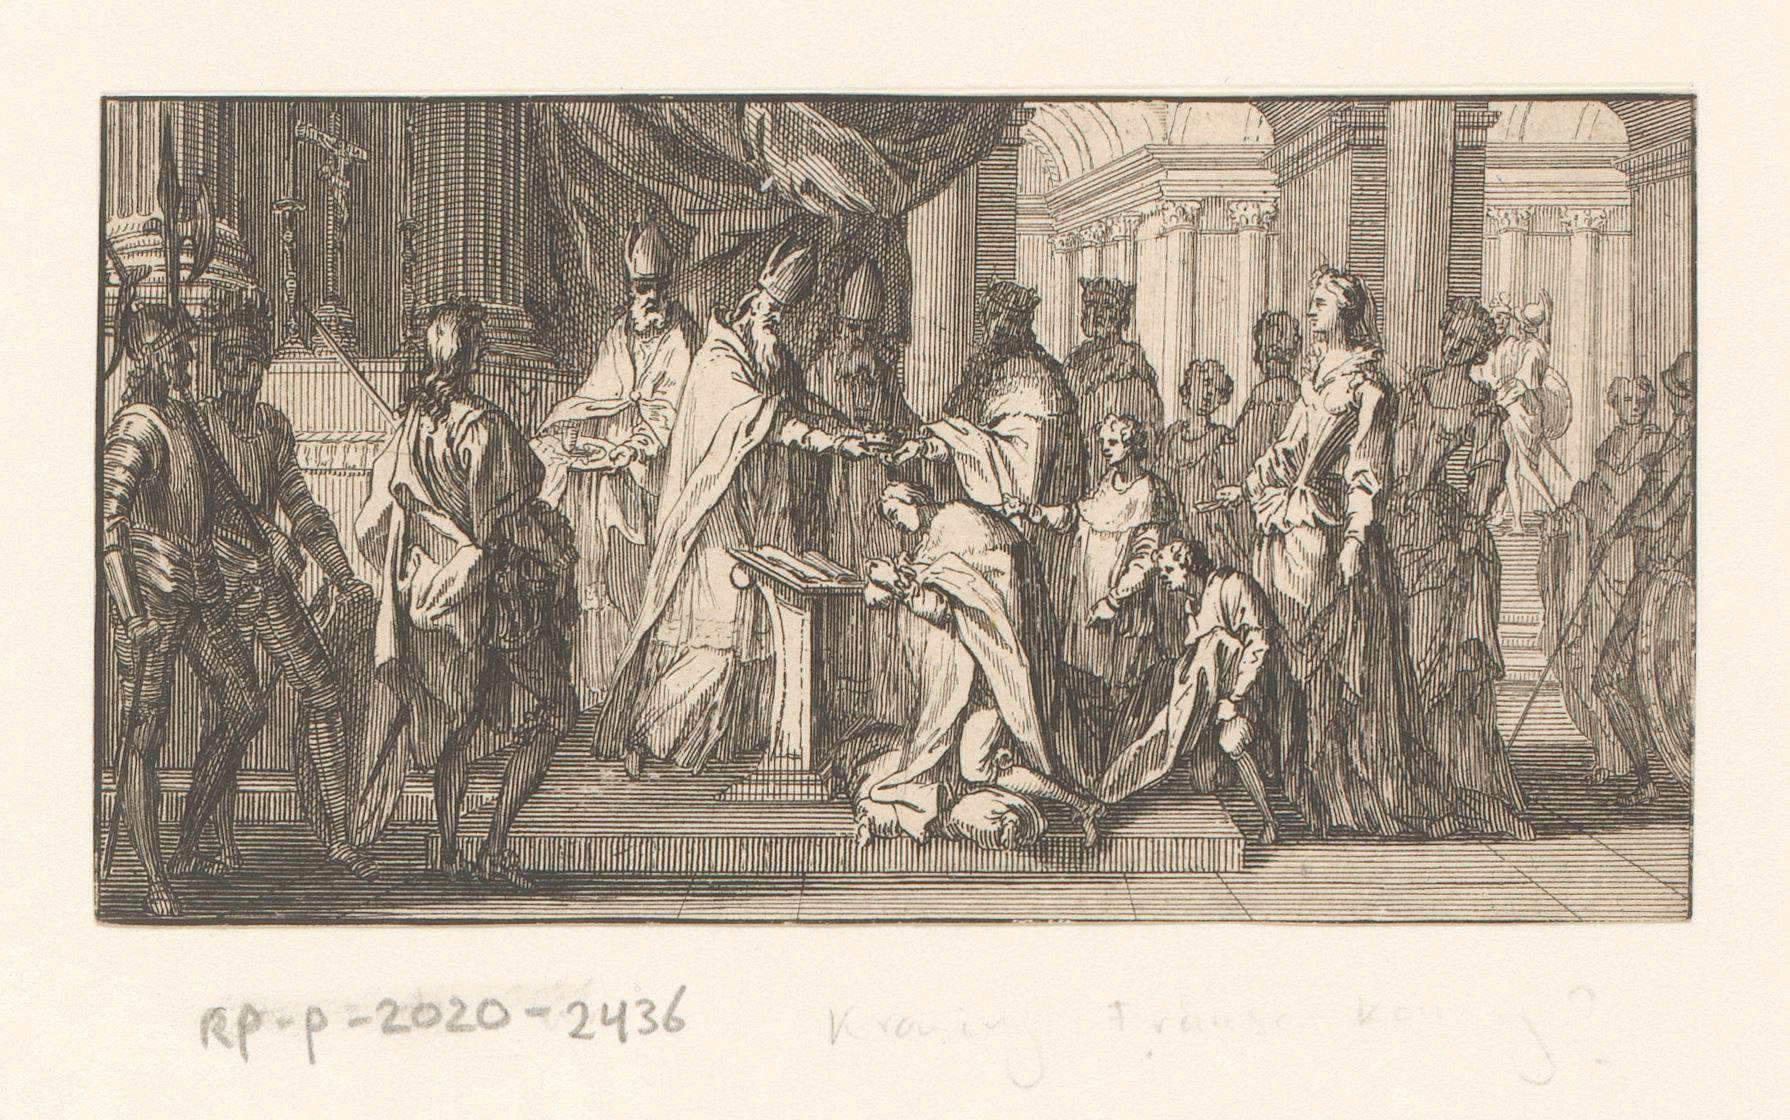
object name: print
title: Kroning, mogelijk van een Franse koning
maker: Anonymous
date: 1730-1780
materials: paper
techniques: etching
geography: france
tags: during the coronation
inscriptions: collector's mark: Lugt 2228